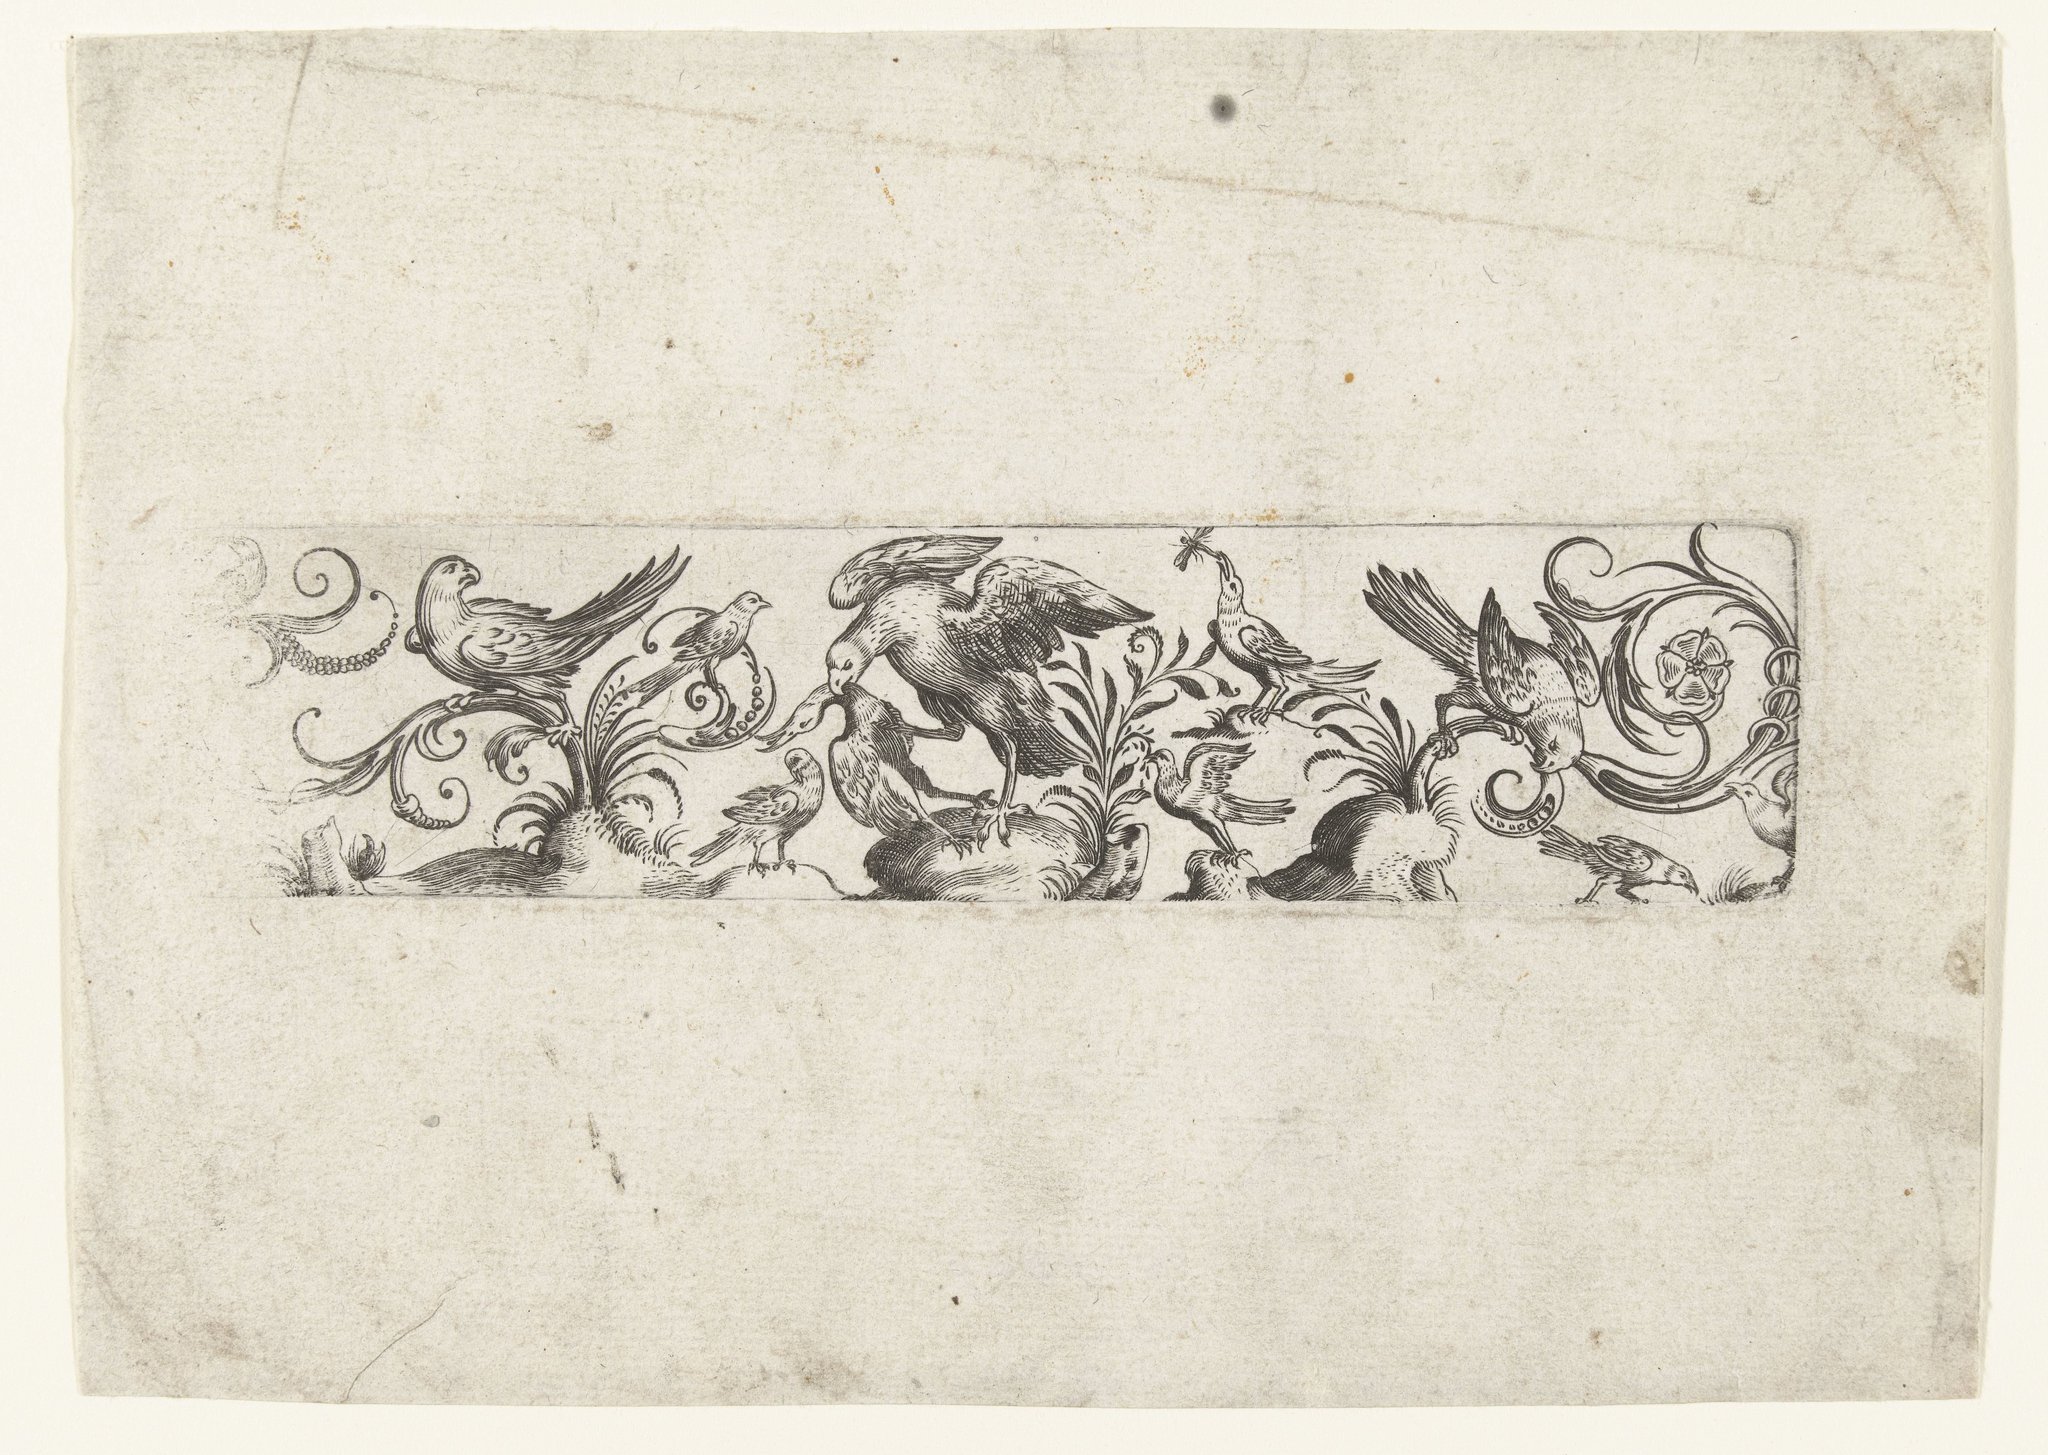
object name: ornament print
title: Fries met elf vogels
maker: Anonymous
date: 1520-1581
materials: paper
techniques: engraving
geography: netherlands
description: Aan het linker uiteinde van het fries staat een boom. In het midden bijt een grote vogel een kleinere de hals door.